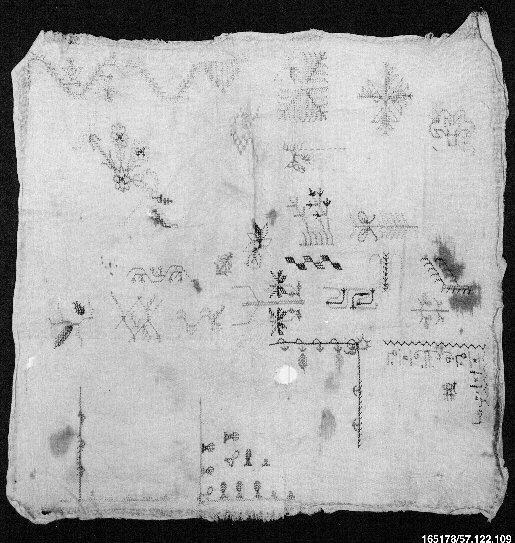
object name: sampler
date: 1801-1900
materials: cotton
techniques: embroidery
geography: turkey